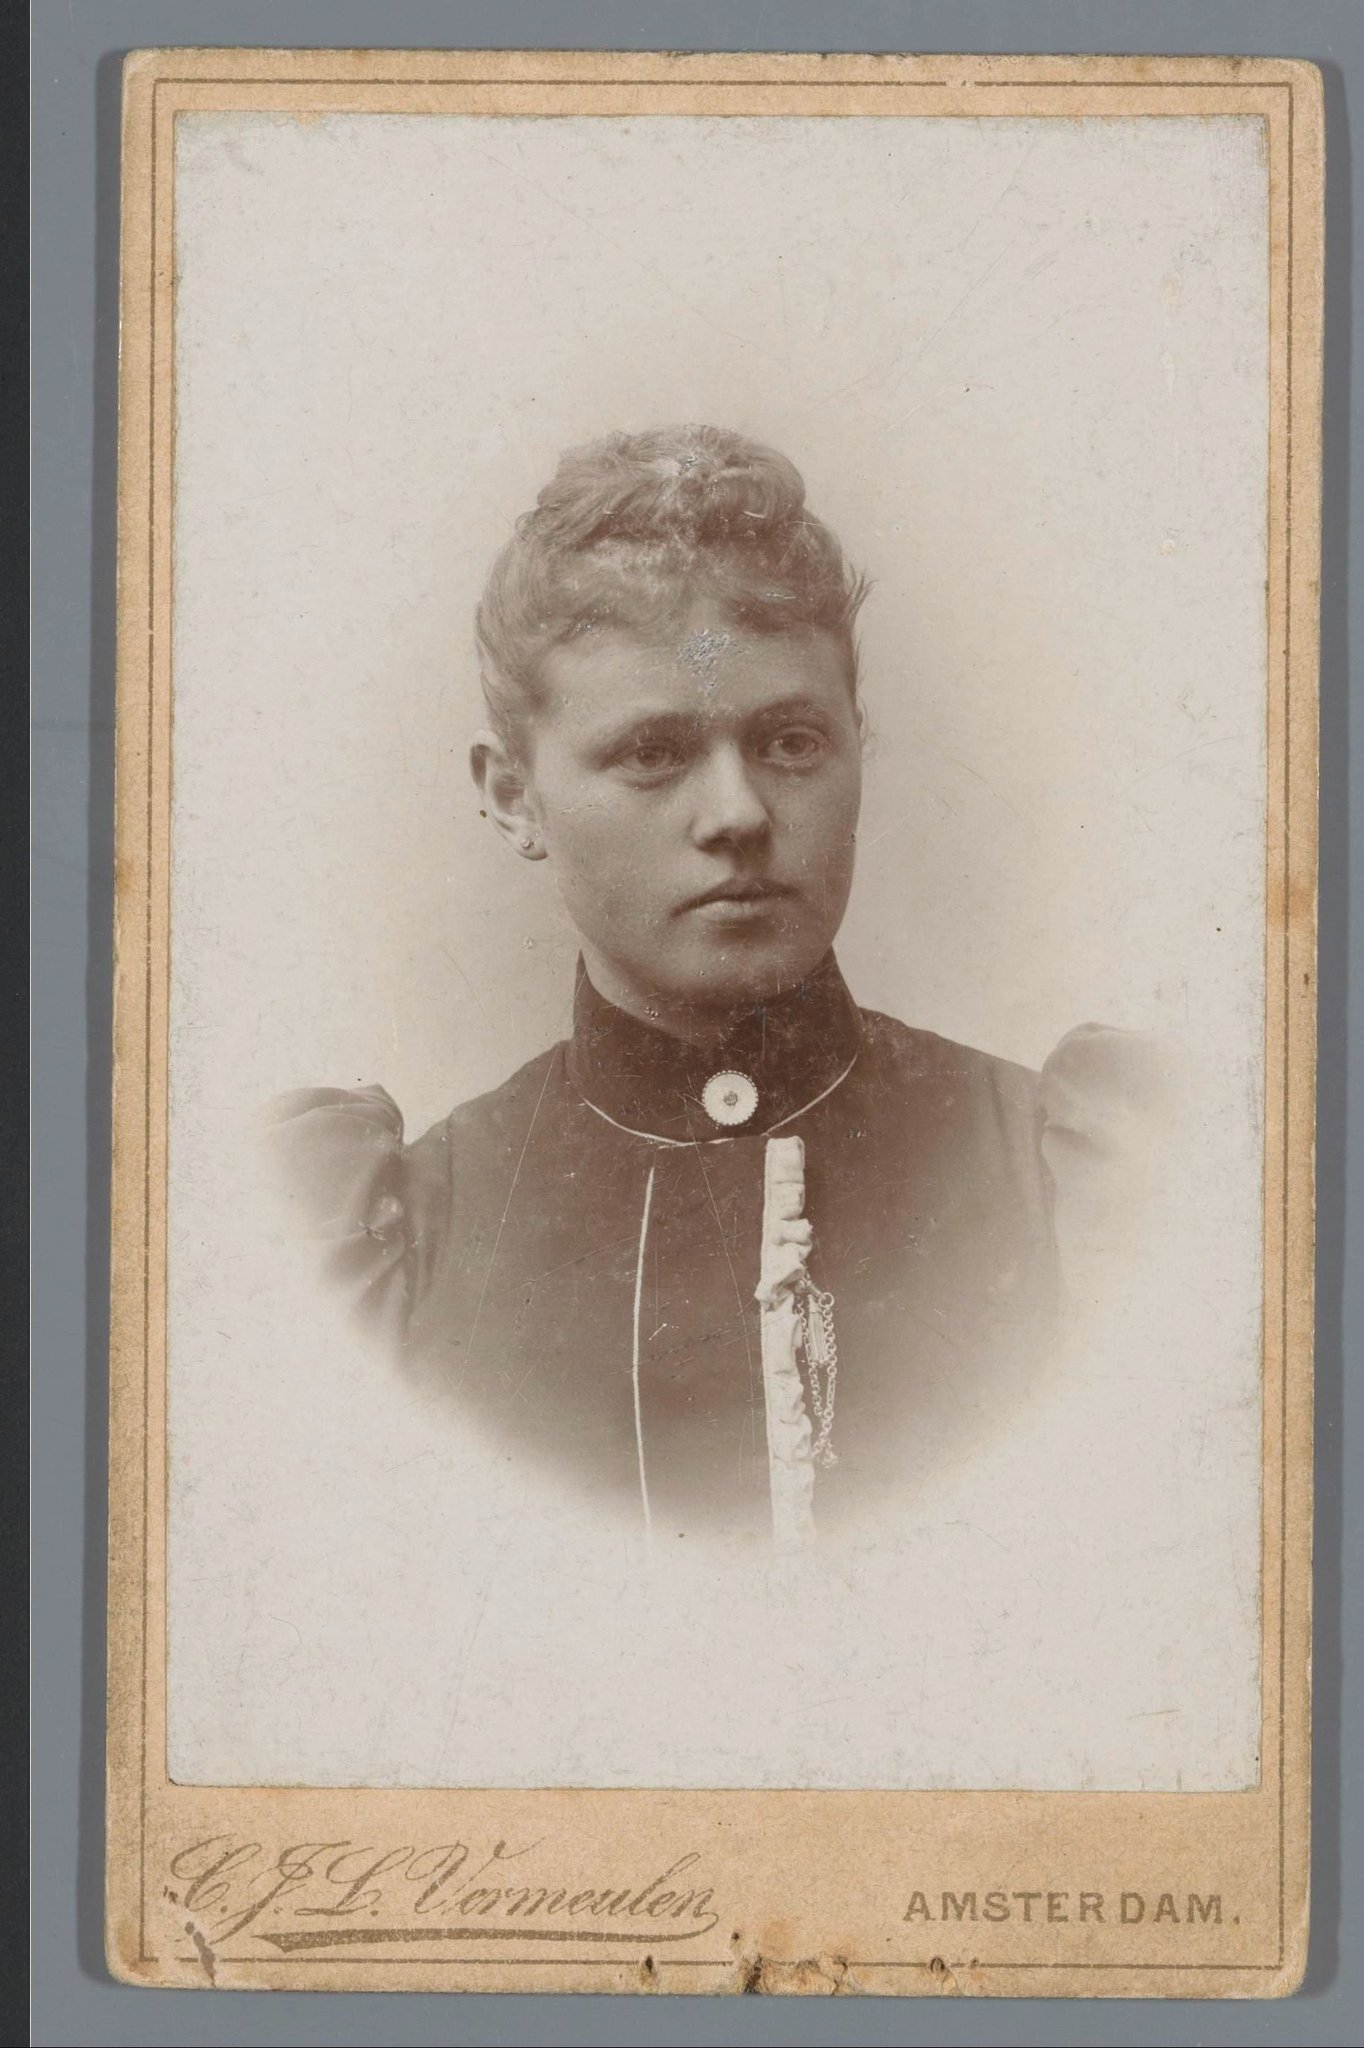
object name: photograph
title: Portret van een onbekende vrouw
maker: cornelis johannes lodewicus vermeulen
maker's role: fotograaf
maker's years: 1861-1936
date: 1888-1896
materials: cardboard, photographic support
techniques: collodion silver print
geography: amsterdam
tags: historical persons - bb - woman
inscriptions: inscription: ‘Photographische/ ATELIERS/ C. J. L. Vermeulen/ Heerenstraat 6,/ Heiligenweg/ hoek Singel/ AMSTERDAM./ Specialiteit in vergrootingen.’